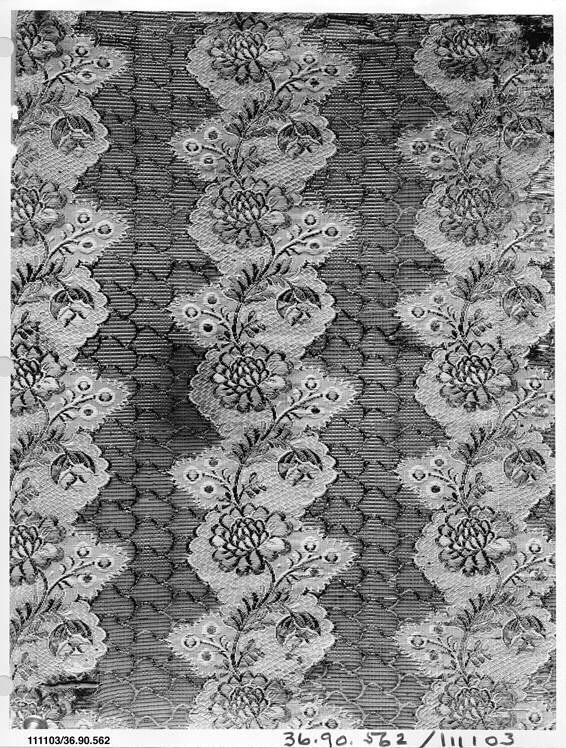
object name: piece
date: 1767-1800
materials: silk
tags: flowers,leaves